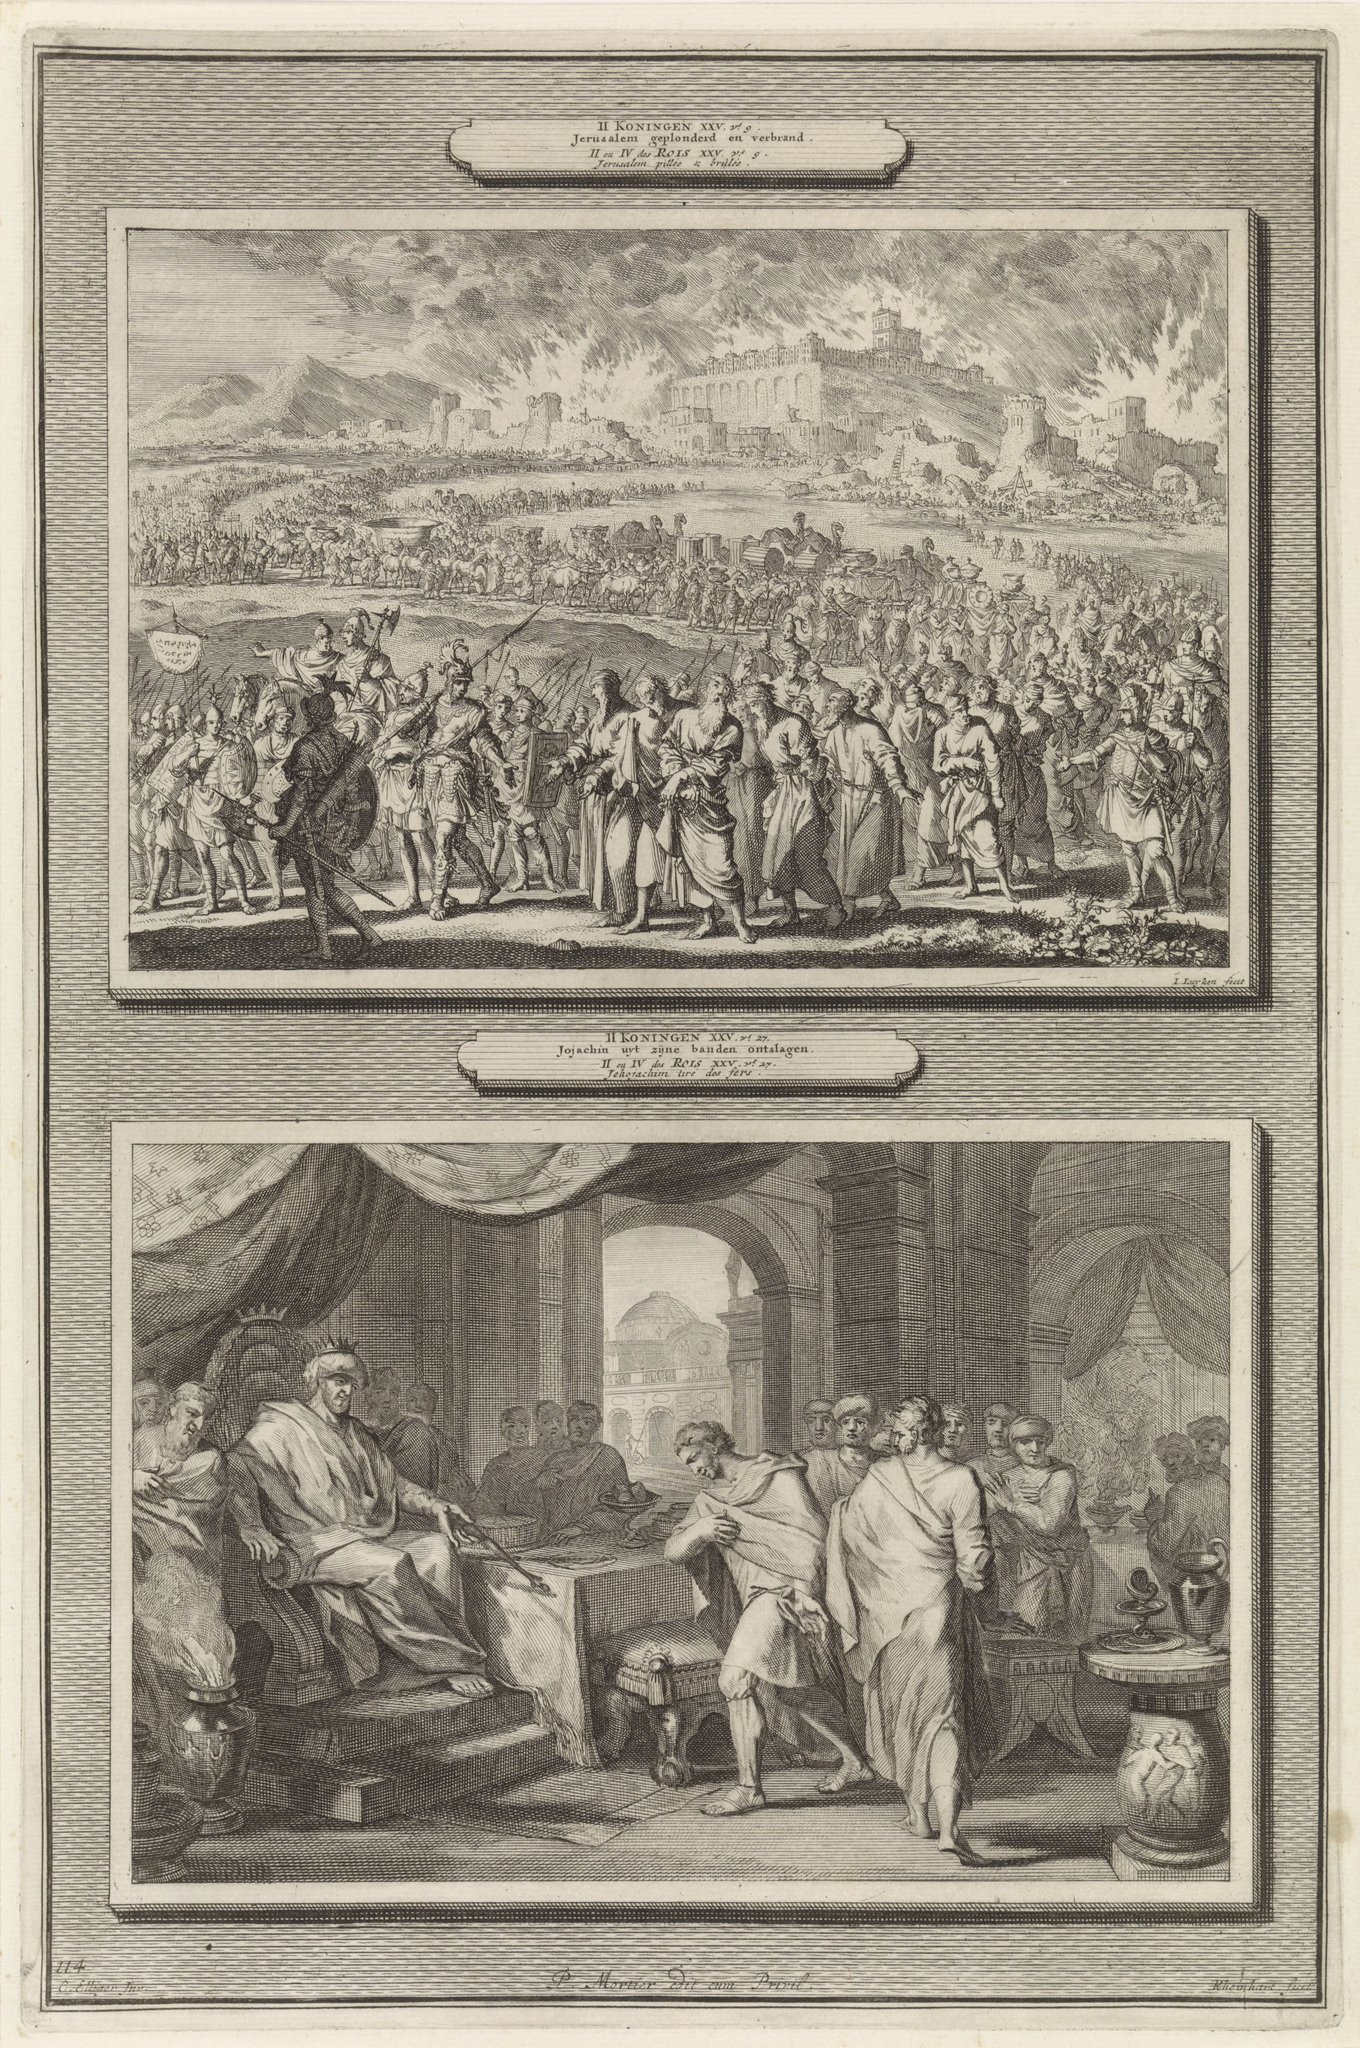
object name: book illustration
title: II Koningen XXV vs. 9: Jerusalem geplonderd en verbrand / II Koningen XXV vs. 27: Jojachim uyt zijne banden ontslagen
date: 1700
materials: paper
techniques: etching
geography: amsterdam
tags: the people of judah, except the poorest, are taken to babylonia ~ story of zedekiah, when evilmerodach becomes king of babylon, jehoiachin is released from prison and permitted to dine at the king's table for the rest of his life (2 kings 25:27-30; jeremiah 52:31-34), nebuzaradan, commander of the babylonian army, burns down the temple and the palace of jerusalem ~ second siege of jerusalem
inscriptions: collector's mark: Lugt 2228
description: Twee voorstellingen op een plaat. Boven: na het beleg van Jeruzalem vertrekt het Babylonische leger terug naar huis met de geplunderde schatten van de stad. De bevolking van Jeruzalem wordt in slavernij meegenomen. Op de achtergrond Jeruzalem in de vlammen. Onder: koning Ewil-Merodach van Babylonië zit op zijn troon en verleent koning Jojakin van Juda gratie. Jojakin buigt in dank.